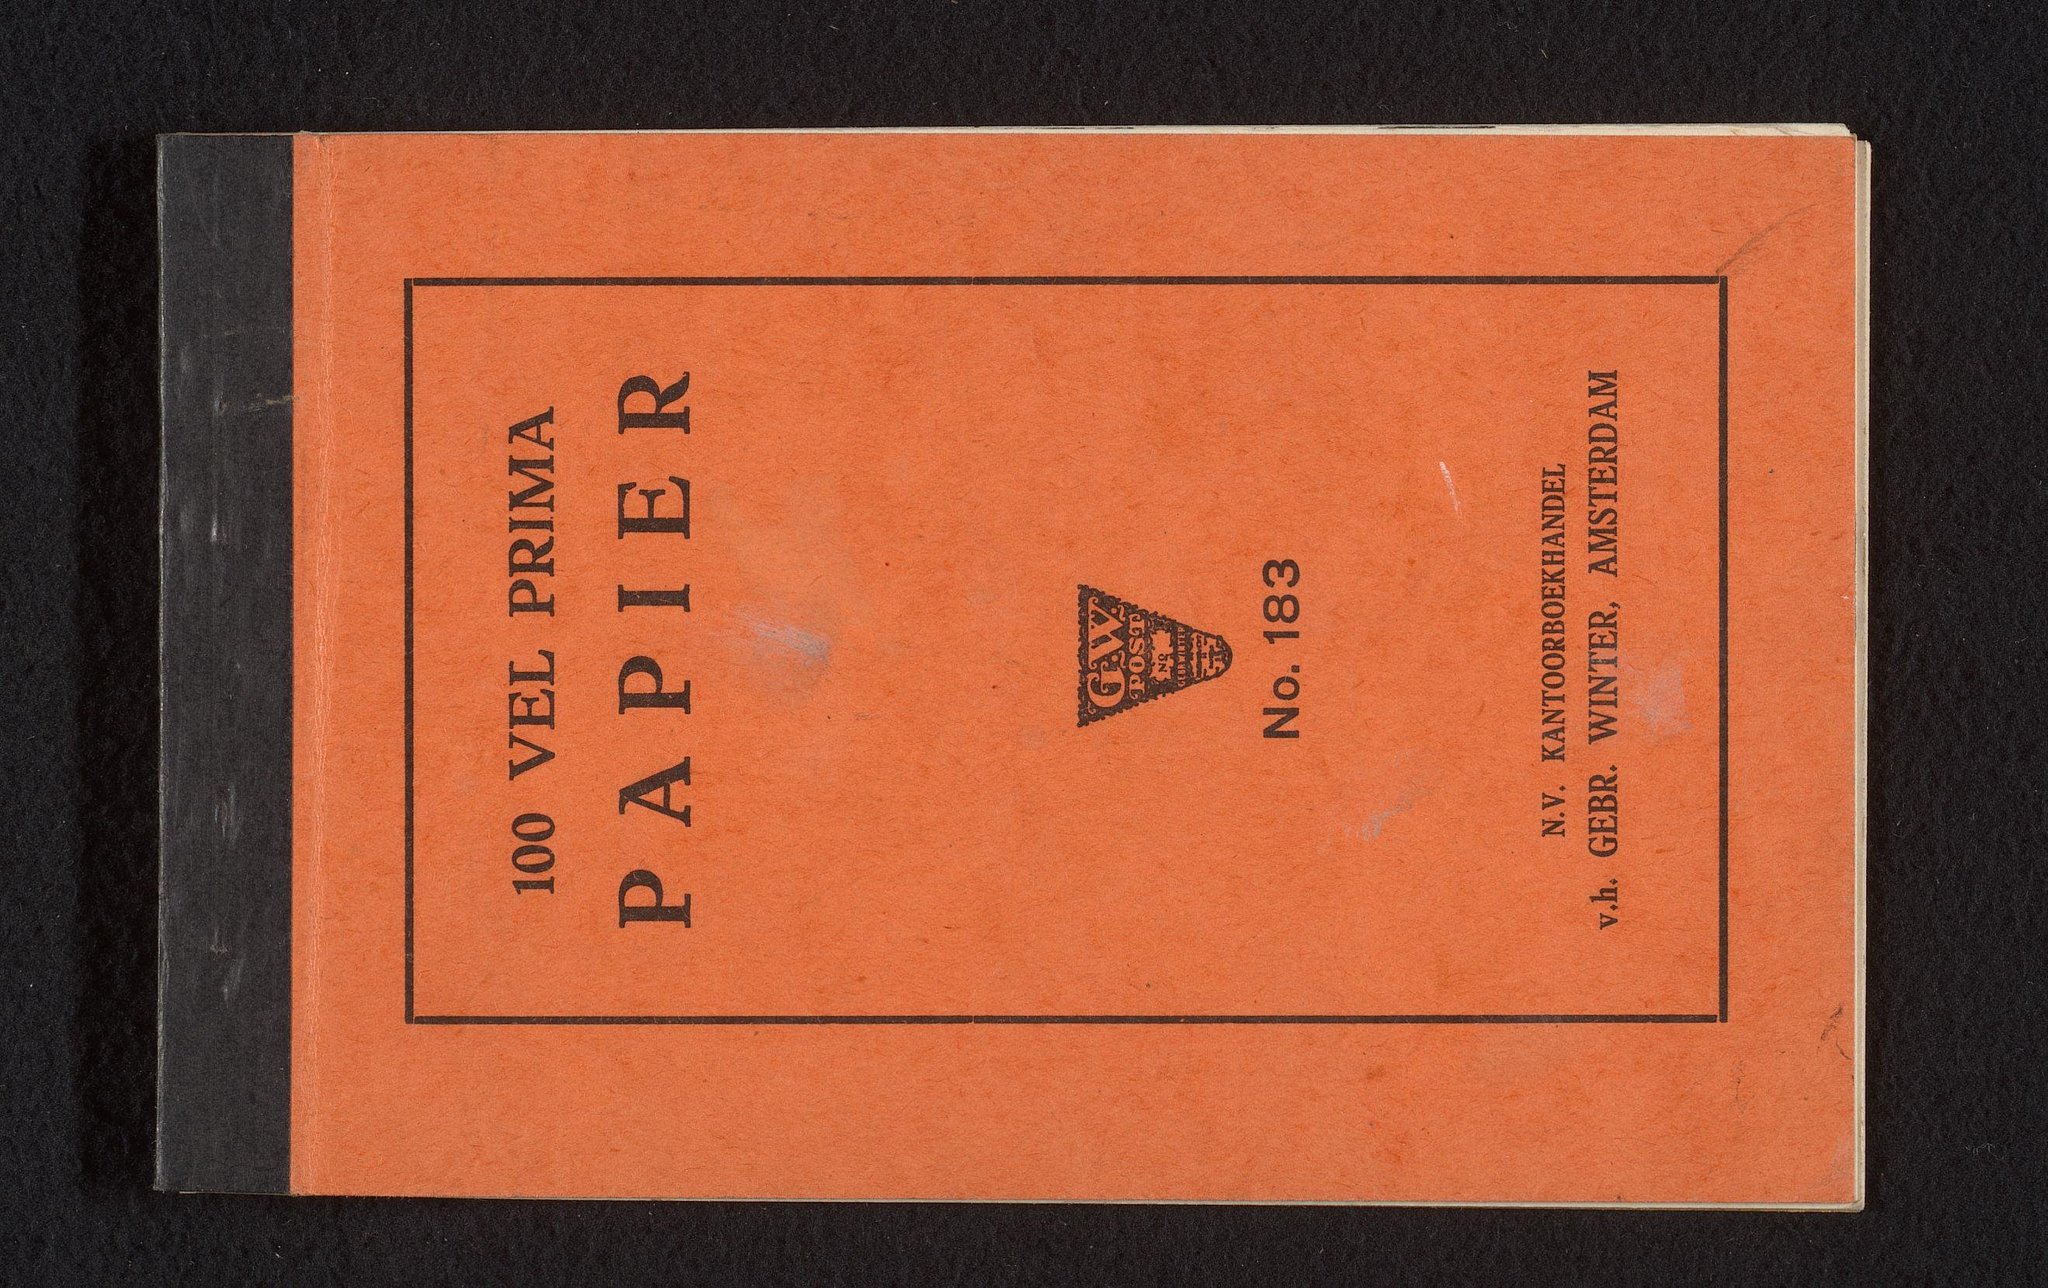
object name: sketchbook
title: Schetsboek met schetsen voor vignetten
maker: leo gestel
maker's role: draughtsman, print maker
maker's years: 1881-1941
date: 1935-1941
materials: ink, paper, pencil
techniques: brush, drawing, pen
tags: vignette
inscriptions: workshop stamp: Lugt 1078a, inscription: ‘verzameling krabbels voor vignetten’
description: Schetsboek met schetsen voor vignetten, met tekeningen van een clown, duif, paarden en een pauw.